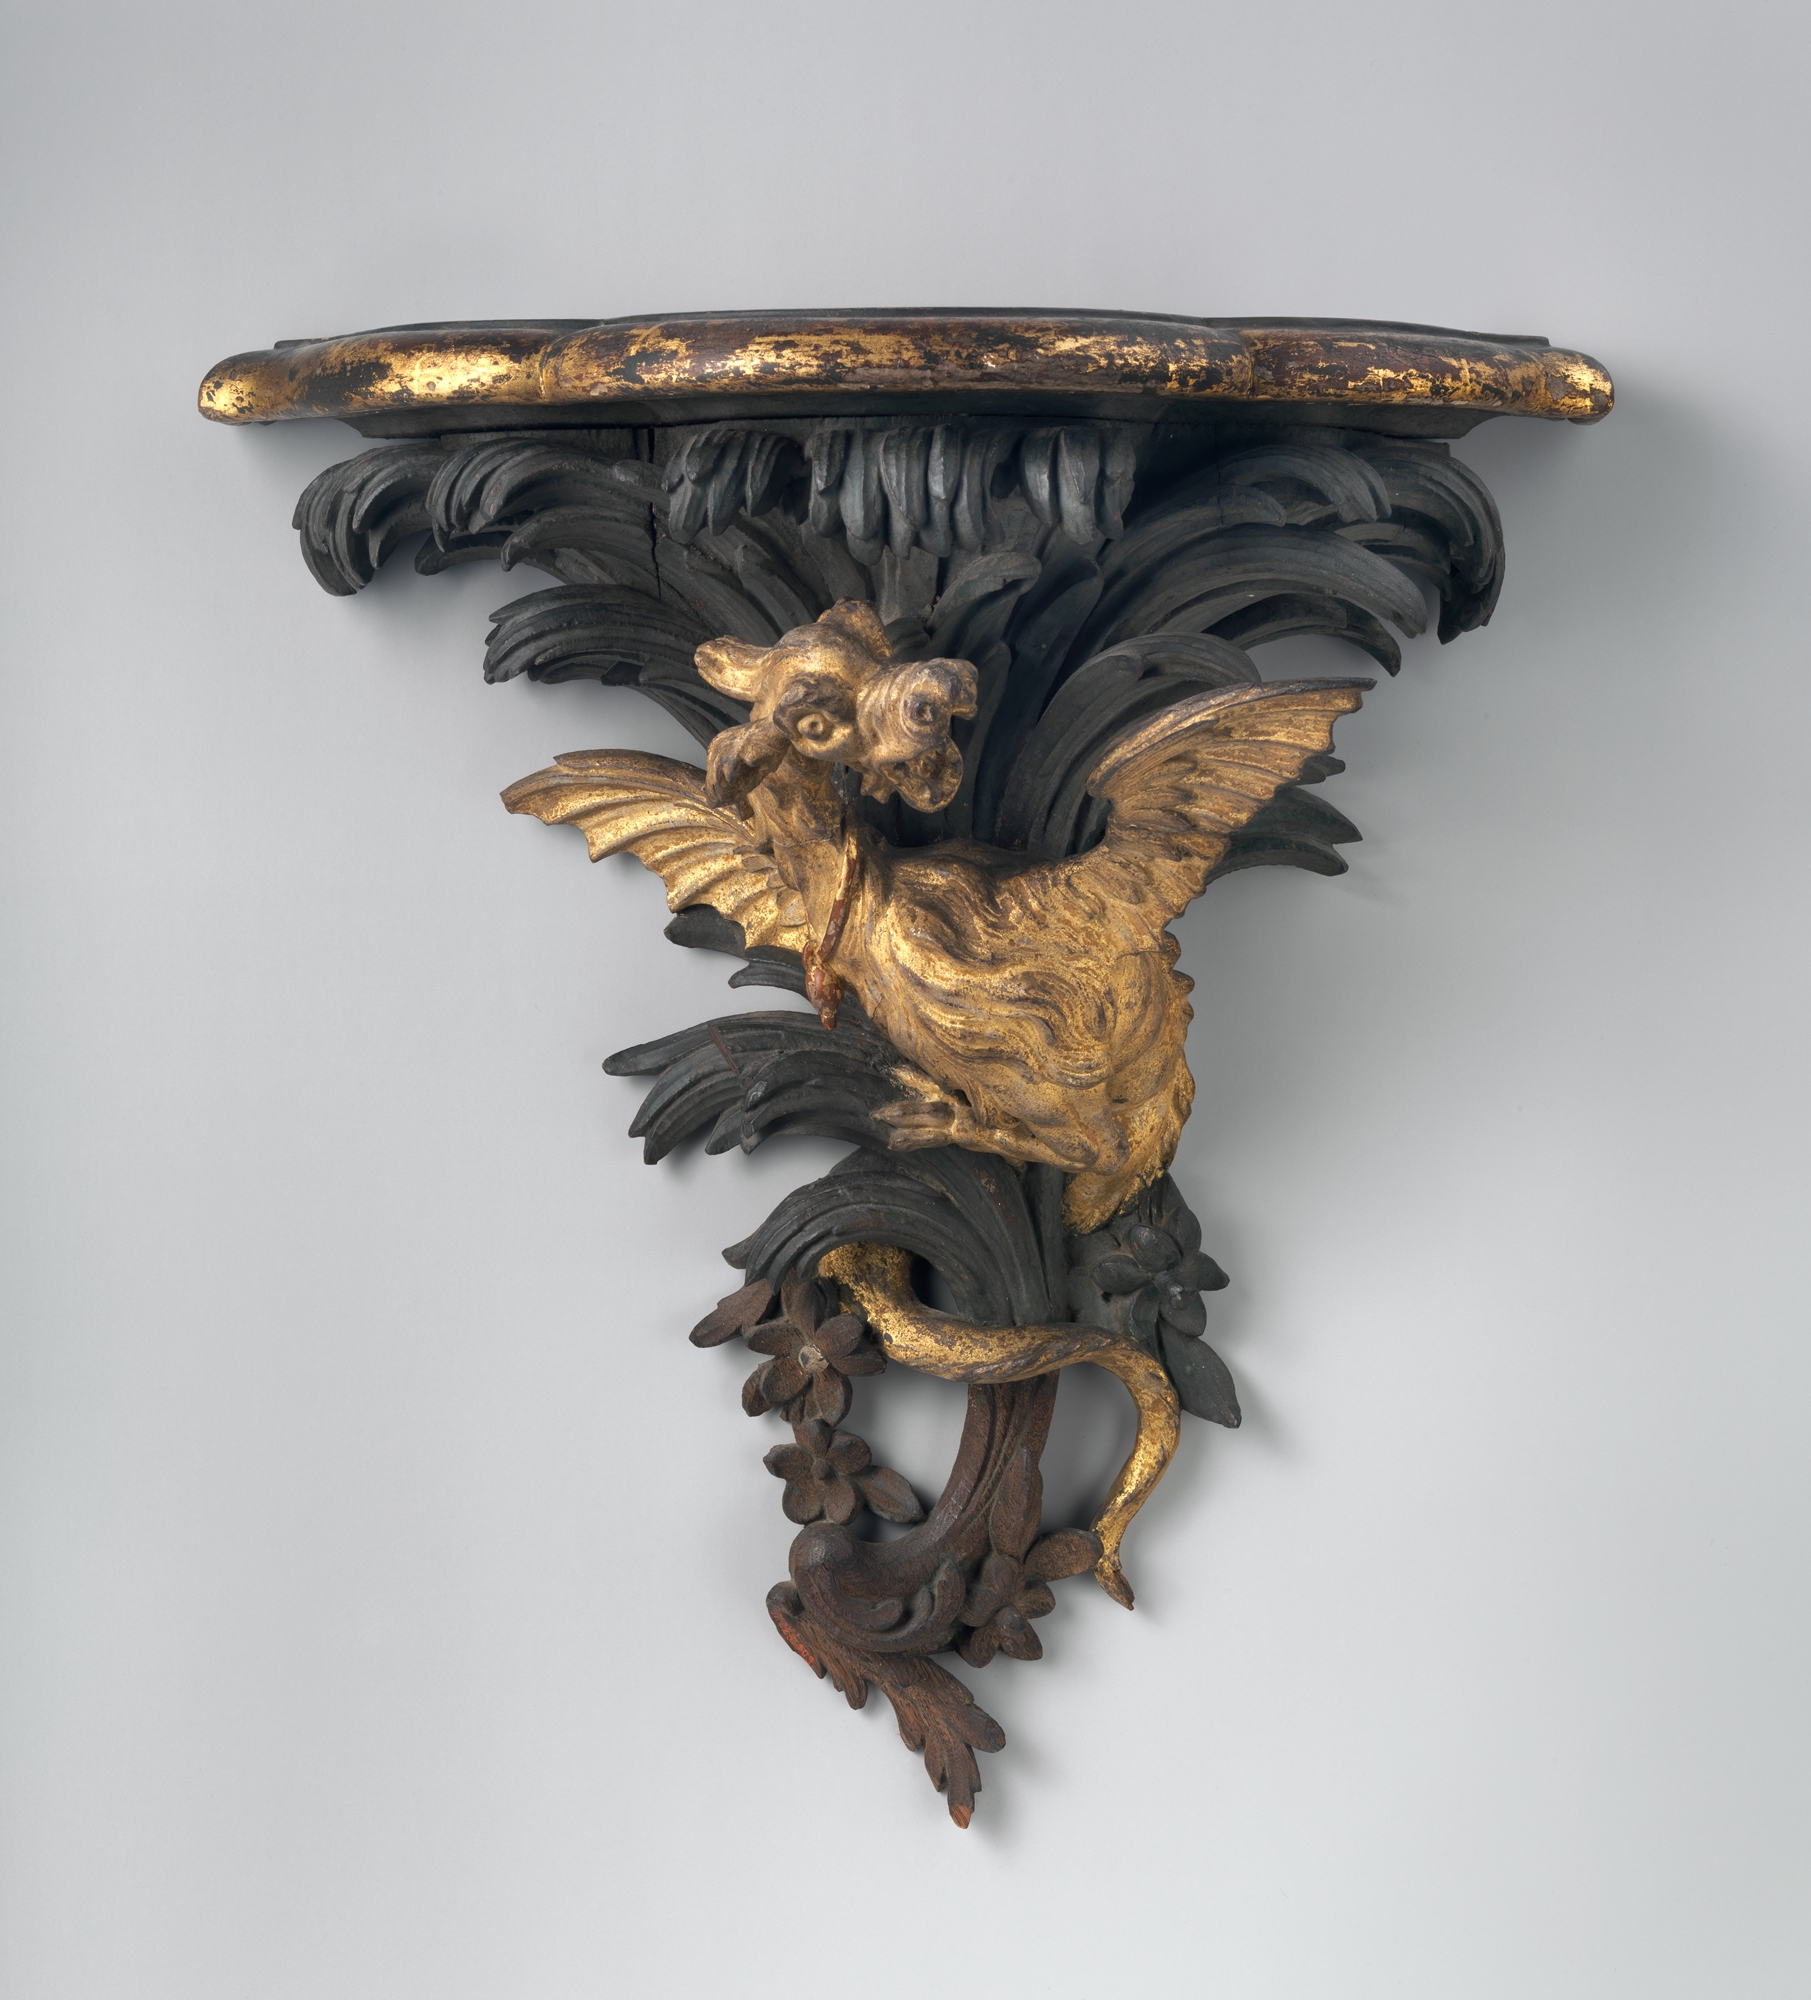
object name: console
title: Console (console d'applique)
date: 1720-1730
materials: wood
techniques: carving, gilding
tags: dragons,flowers,furniture